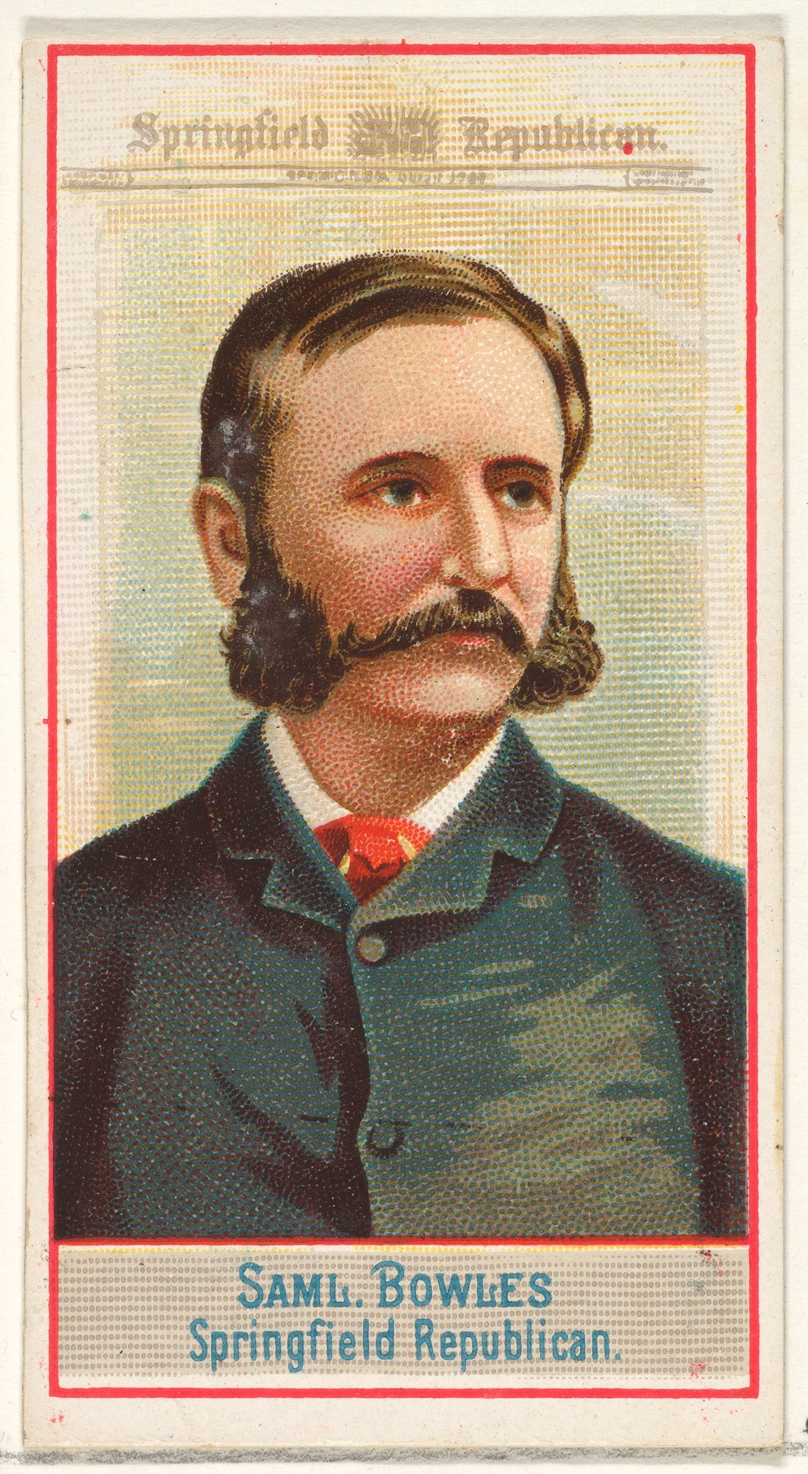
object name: print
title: Samuel Bowles, Springfield Republican, from the American Editors series (N1) for Allen & Ginter Cigarettes Brands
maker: allen & ginter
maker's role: publisher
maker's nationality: american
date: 1887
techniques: color lithograph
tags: men,portraits